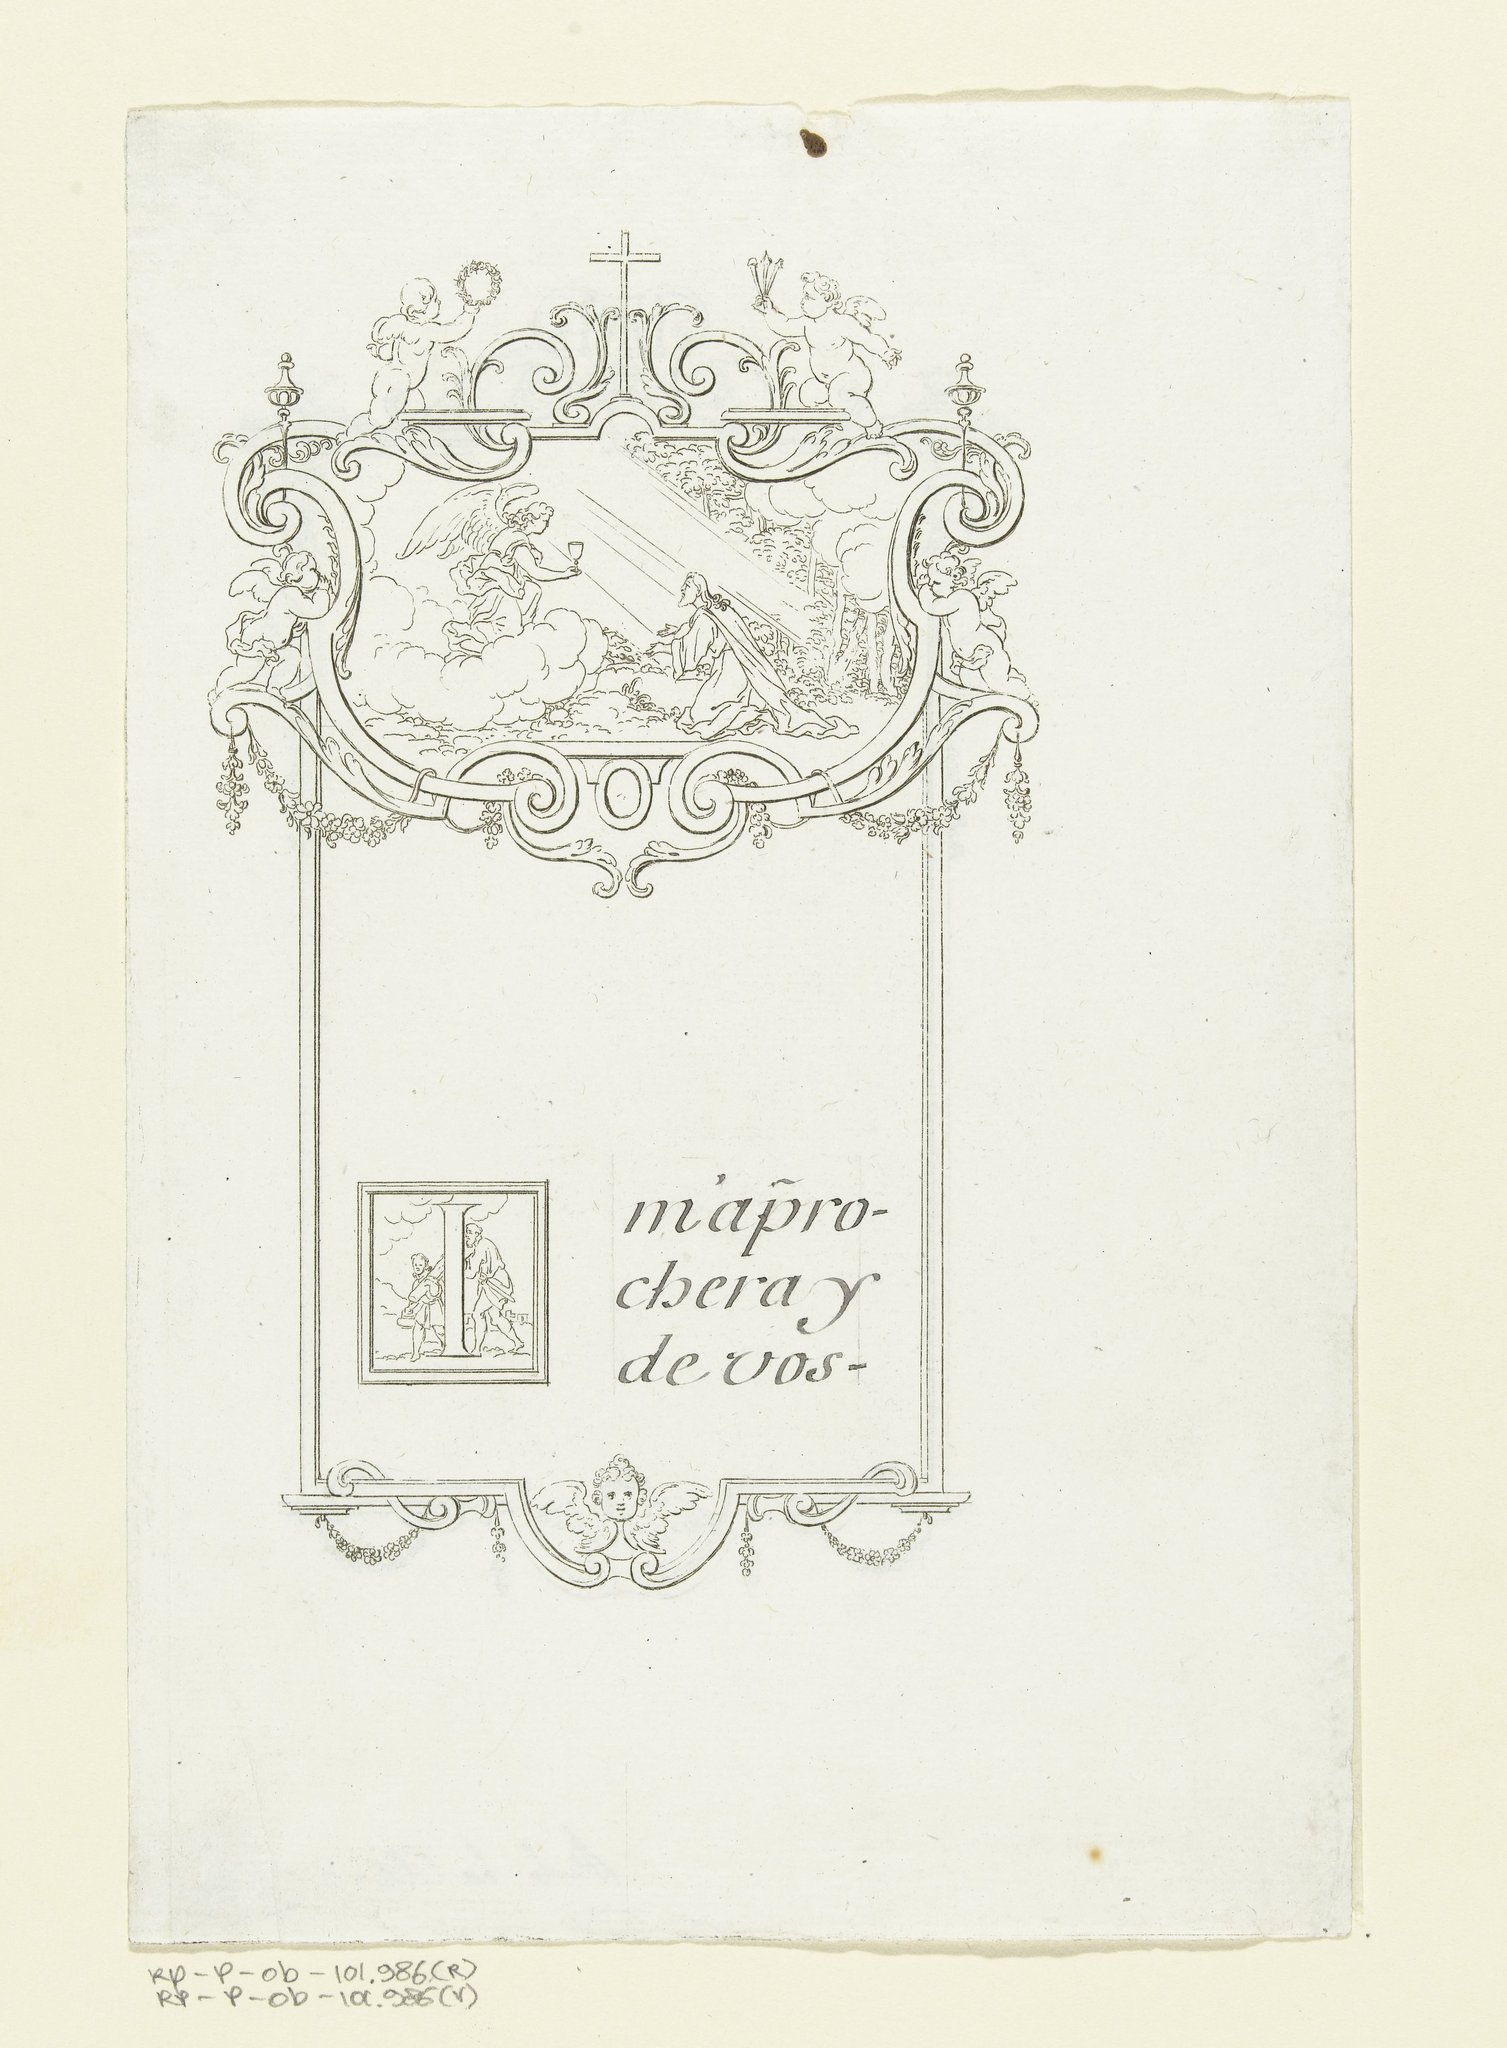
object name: ornament print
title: Boekillustraties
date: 1647-1714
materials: paper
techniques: etching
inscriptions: annotation: ‘m'aprocheray de vos-’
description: In de cartouche bovenaan verschijnt de engel met een beker aan Christus. Linksonder de letter I in een vierkante omlijsting.